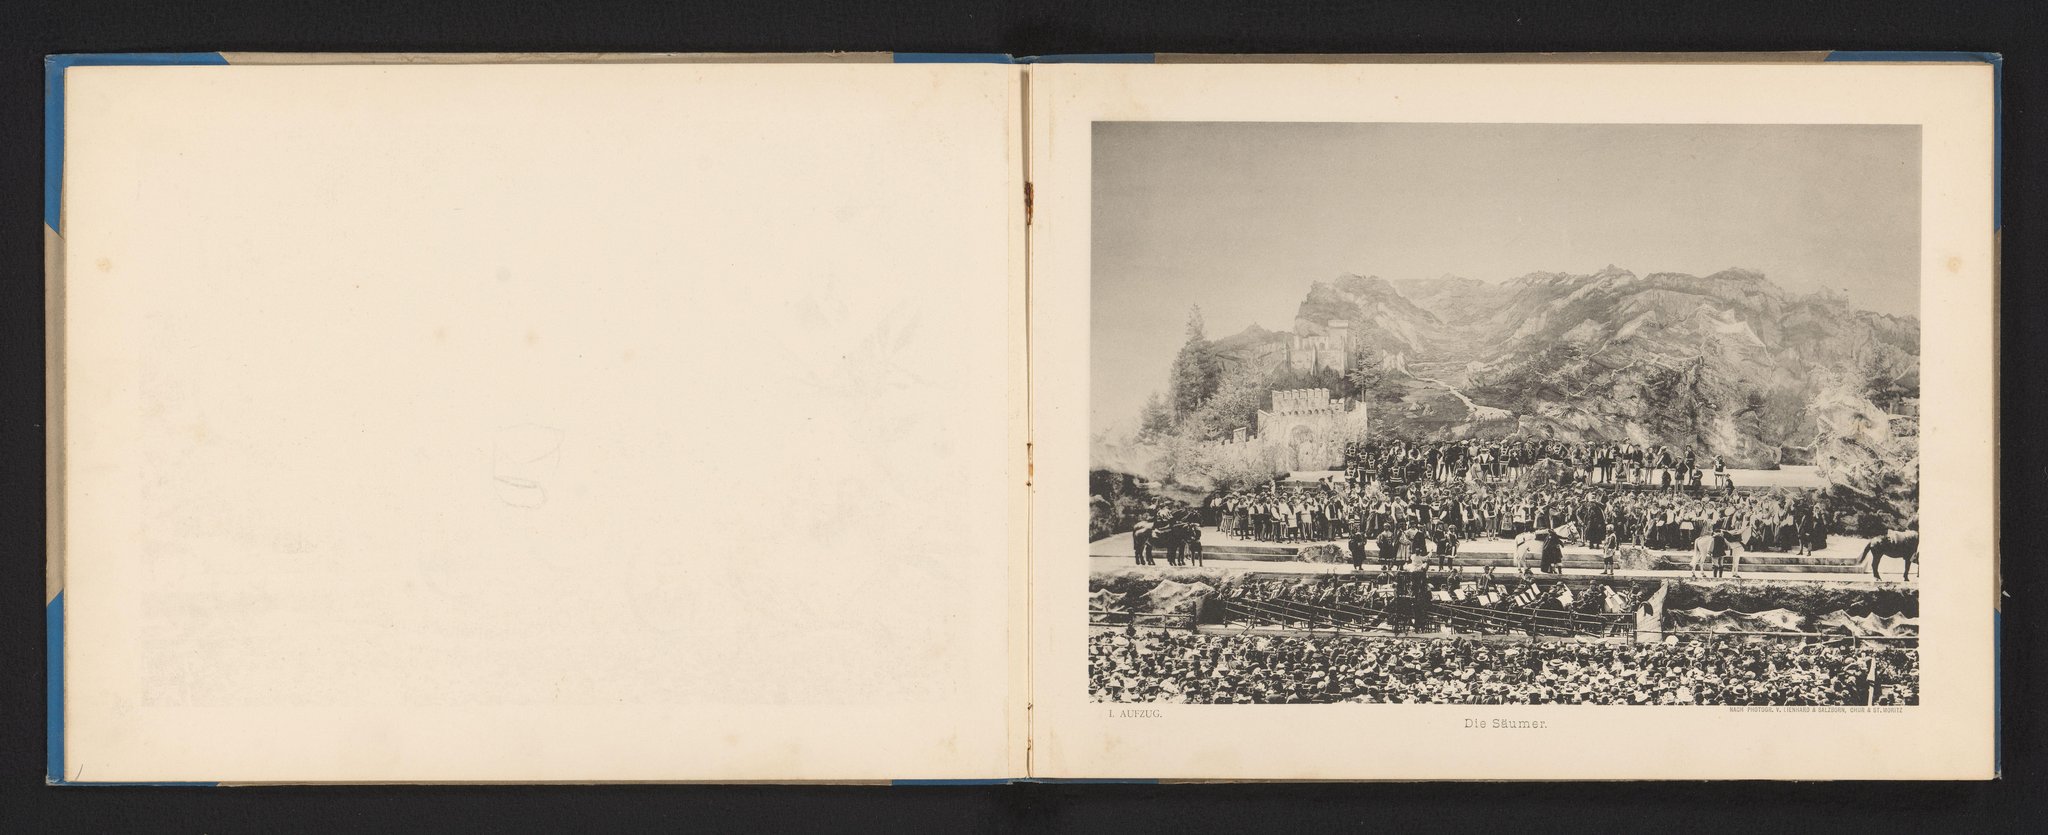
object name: photomechanical print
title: Die Säumer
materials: paper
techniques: photograph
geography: chur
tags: activities in the air ~ public festivities, e.g. fly-past, mule, mountains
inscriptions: number: ‘I.’